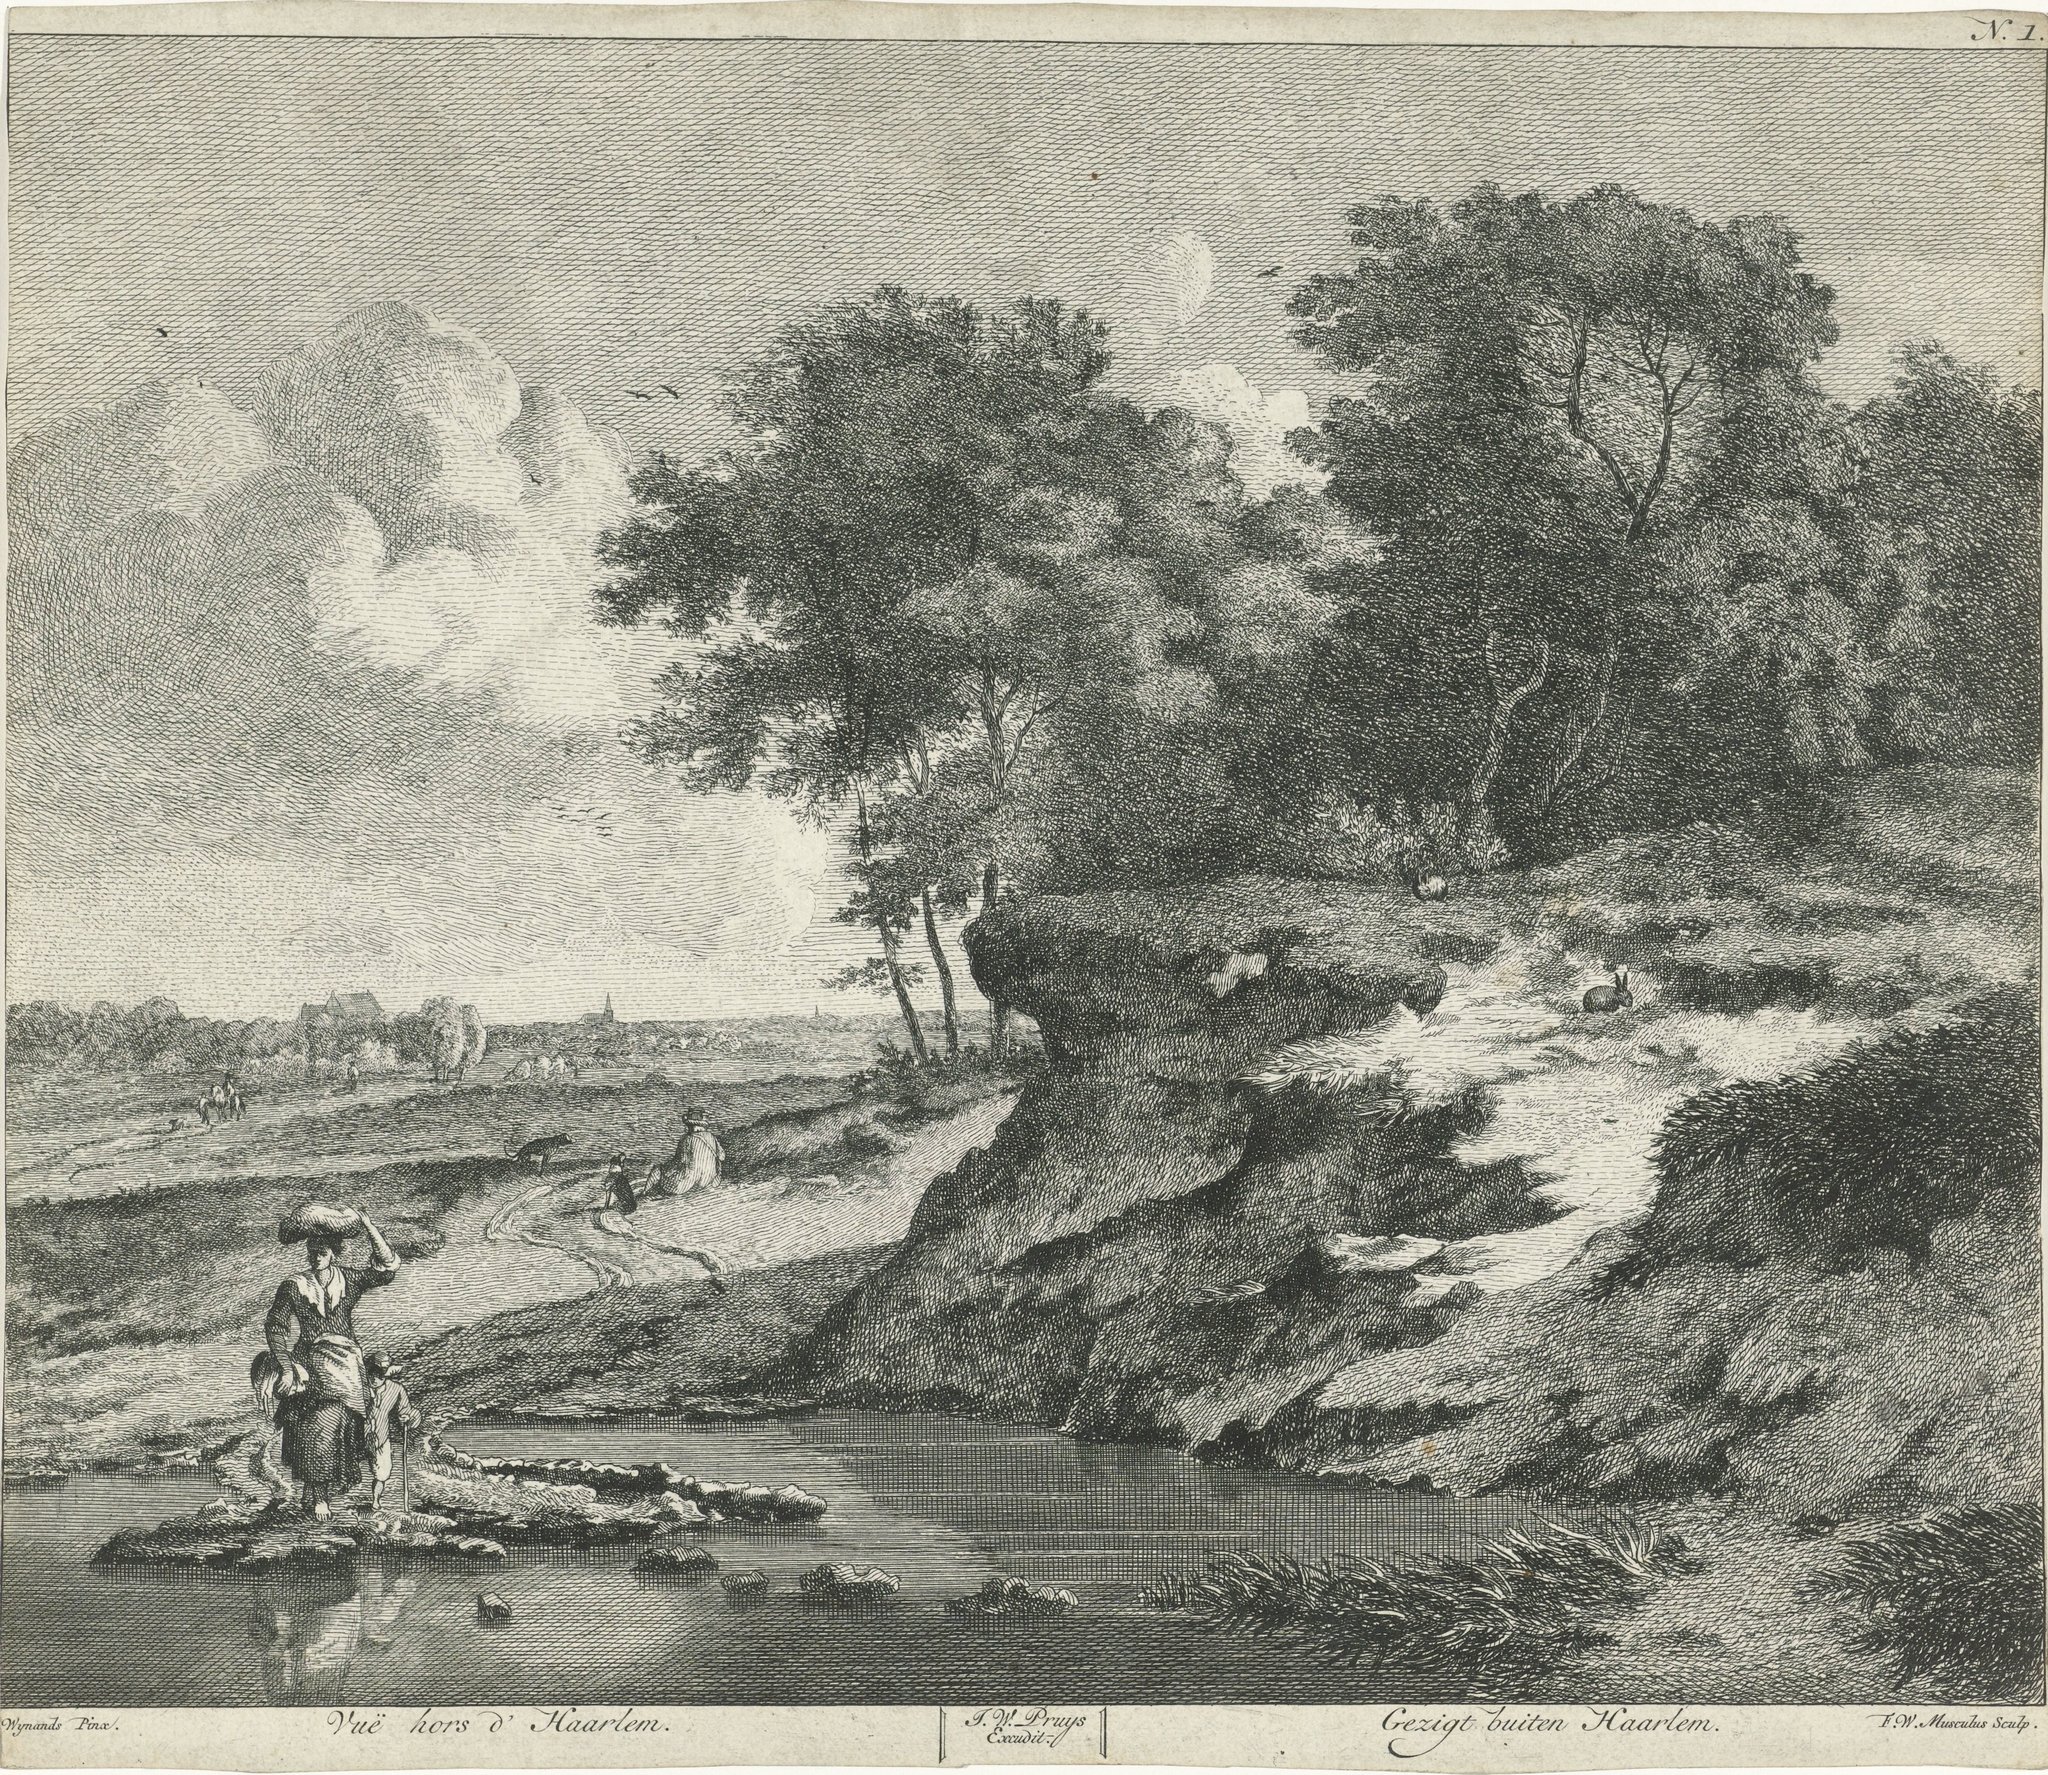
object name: print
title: Vuë hors d' Haarlem / Gezigt buiten Haarlem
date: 1747-1758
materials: paper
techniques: engraving, etching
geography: amsterdam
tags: dunes (sea not visible); in the dunes, carrying something on the head or on the shoulders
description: In een duinlandschap loopt een vrouw met een pak op haar hoofd. Aan de horizon de stad Haarlem.